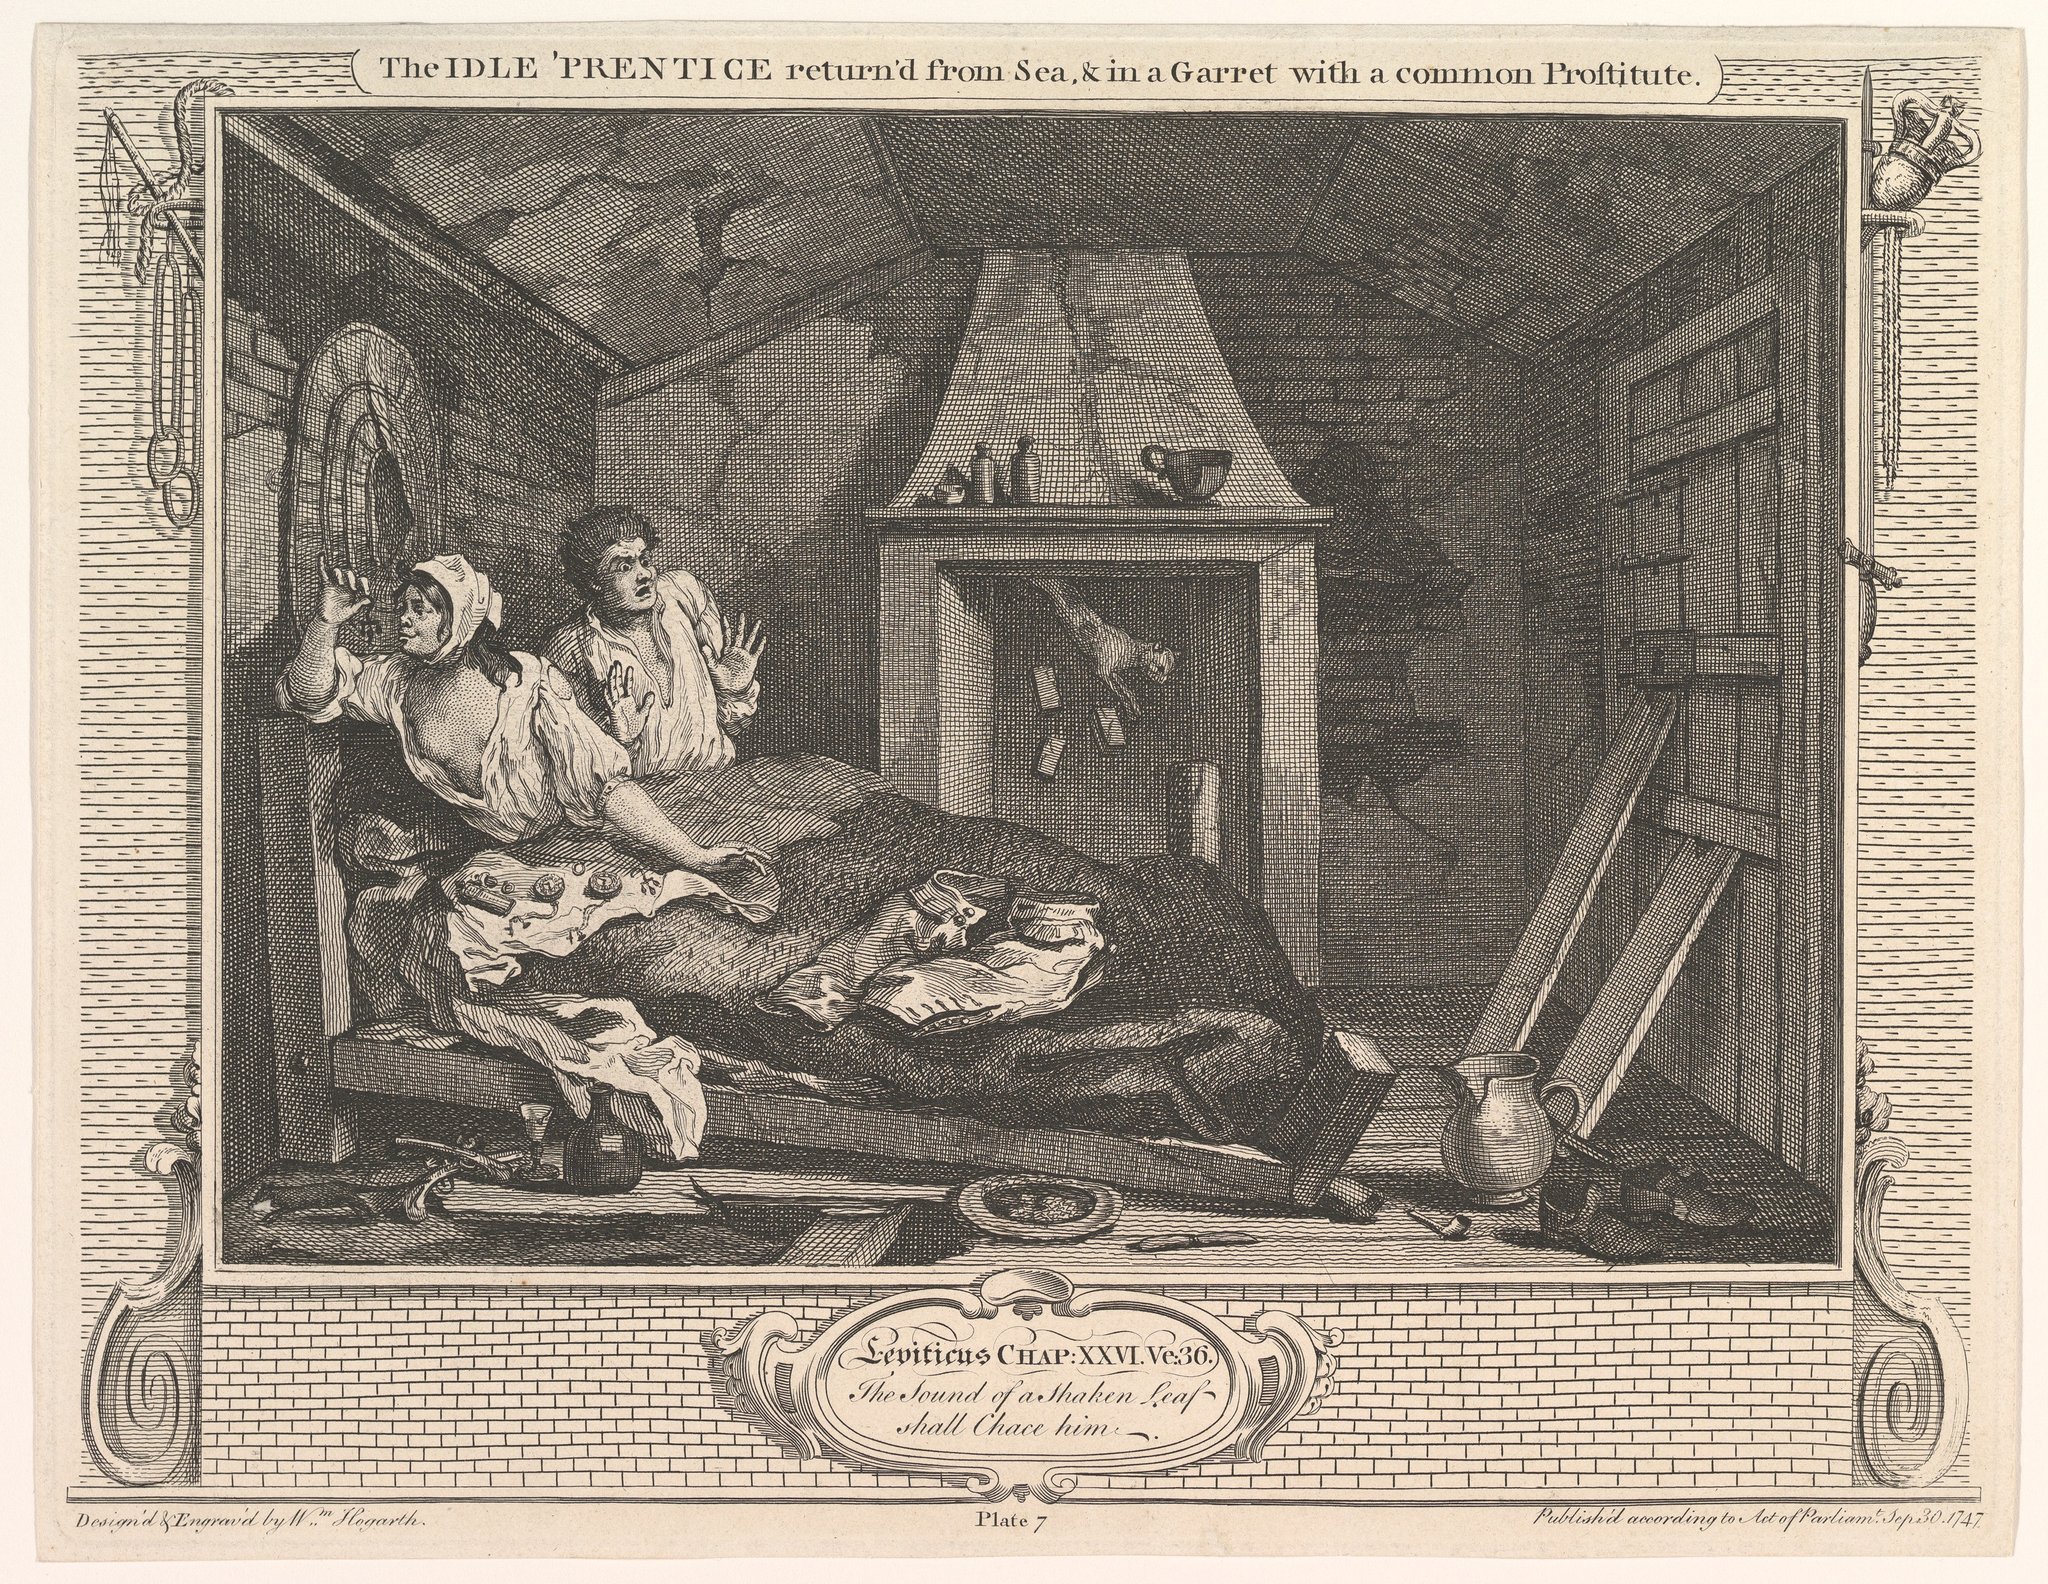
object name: print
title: The Idle 'Prentice Returned from Sea and in a Garret with a Common Prostitute (Industry and Idleness, plate 7)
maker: william hogarth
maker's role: artist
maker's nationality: british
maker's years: 1697-1764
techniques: engraving, etching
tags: bedrooms,men,women,cats,prostitutes